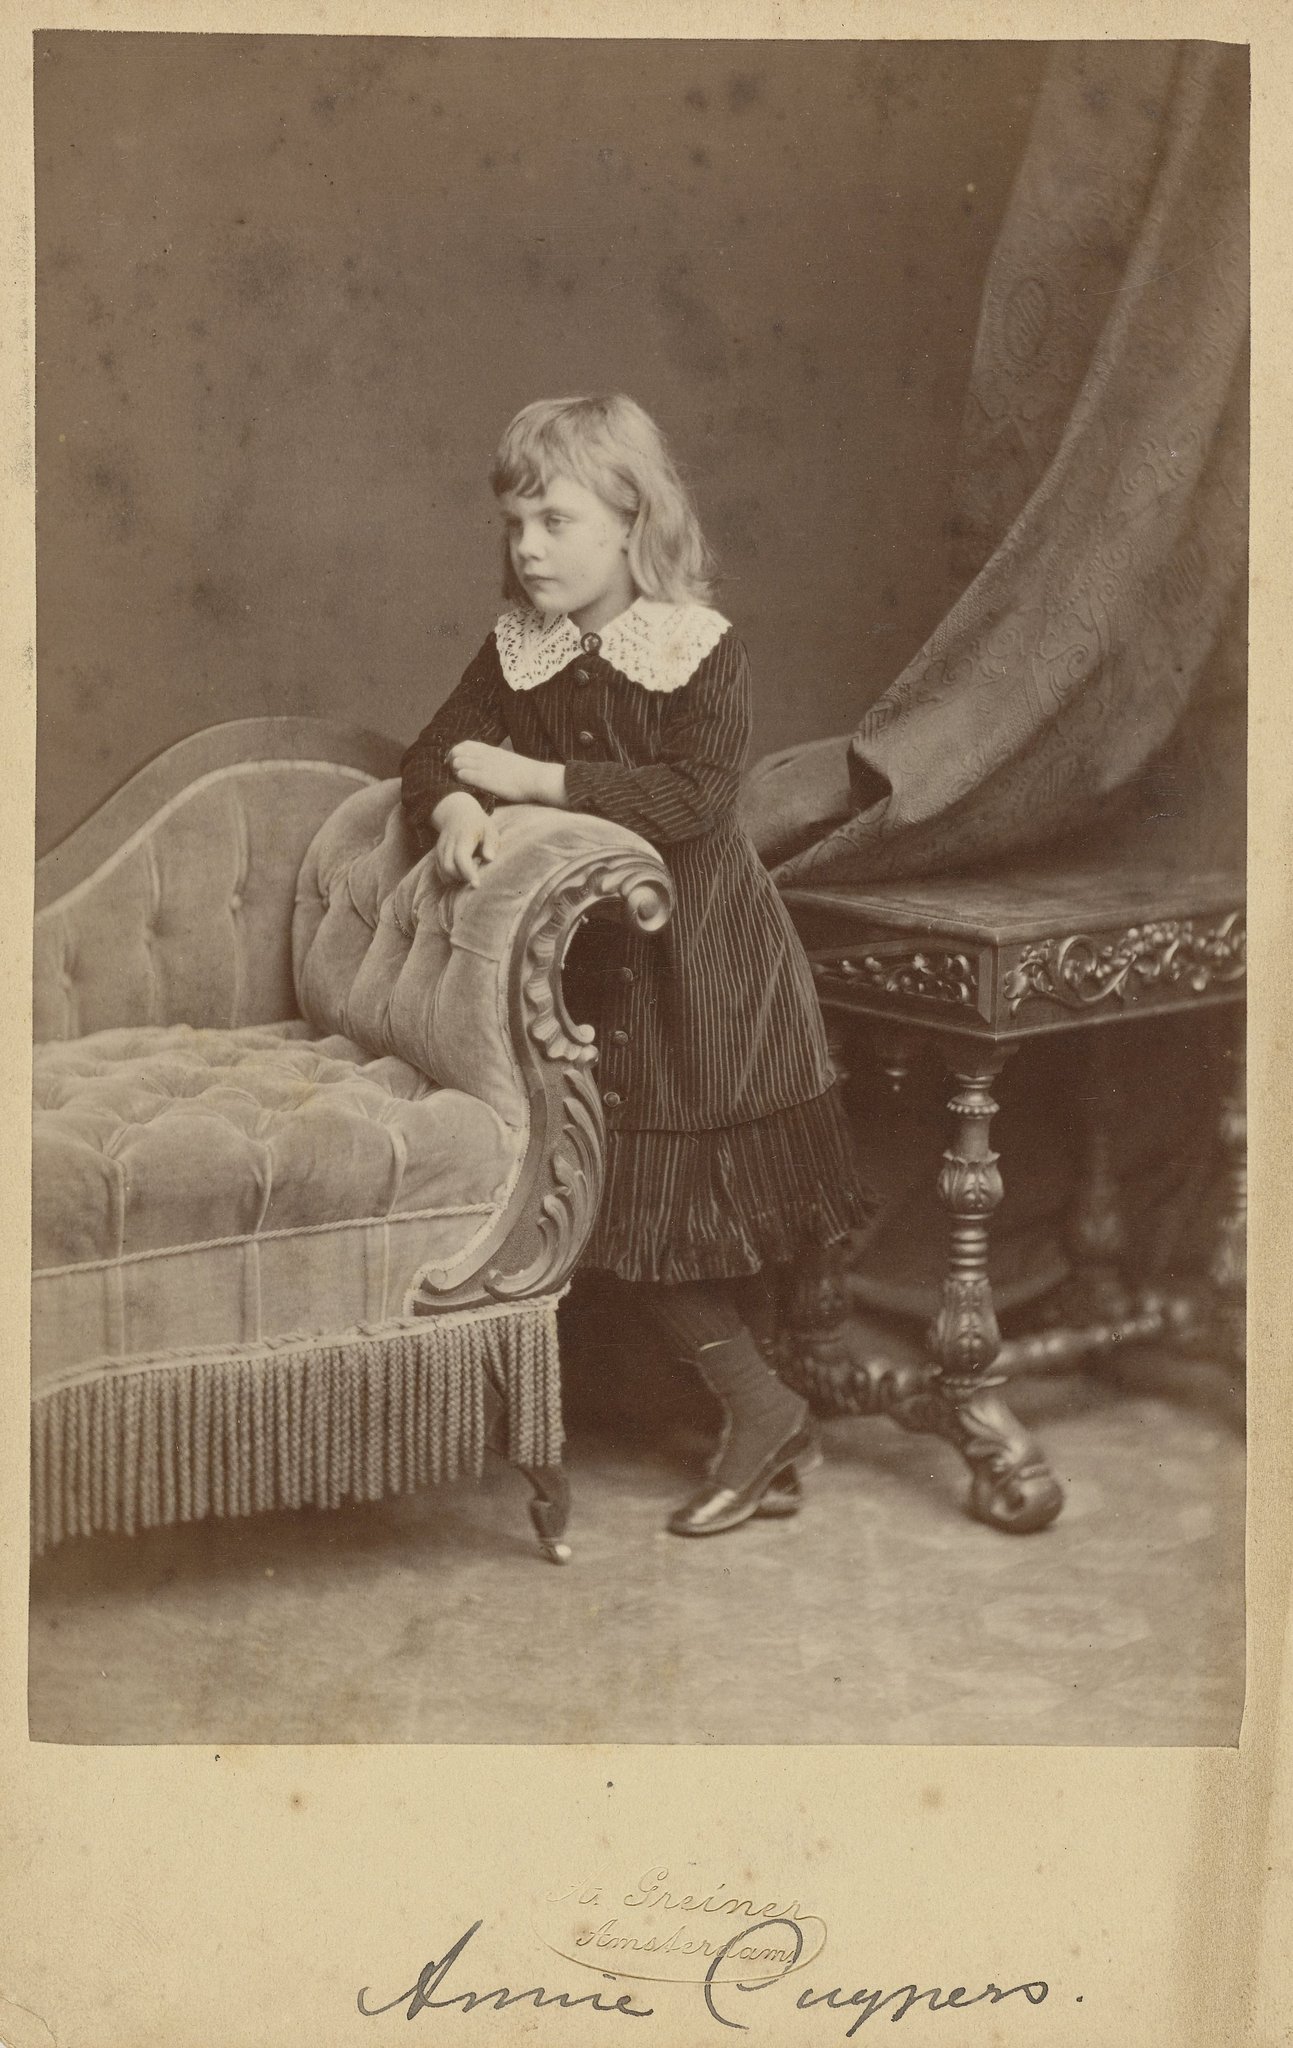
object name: photograph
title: Portret van Annie Cuypers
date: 1850-1899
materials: cardboard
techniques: photography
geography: amsterdam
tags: draughtsman, pierre joseph hubert cuypers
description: Foto op karton, van een vrouw (Annie Cuypers).